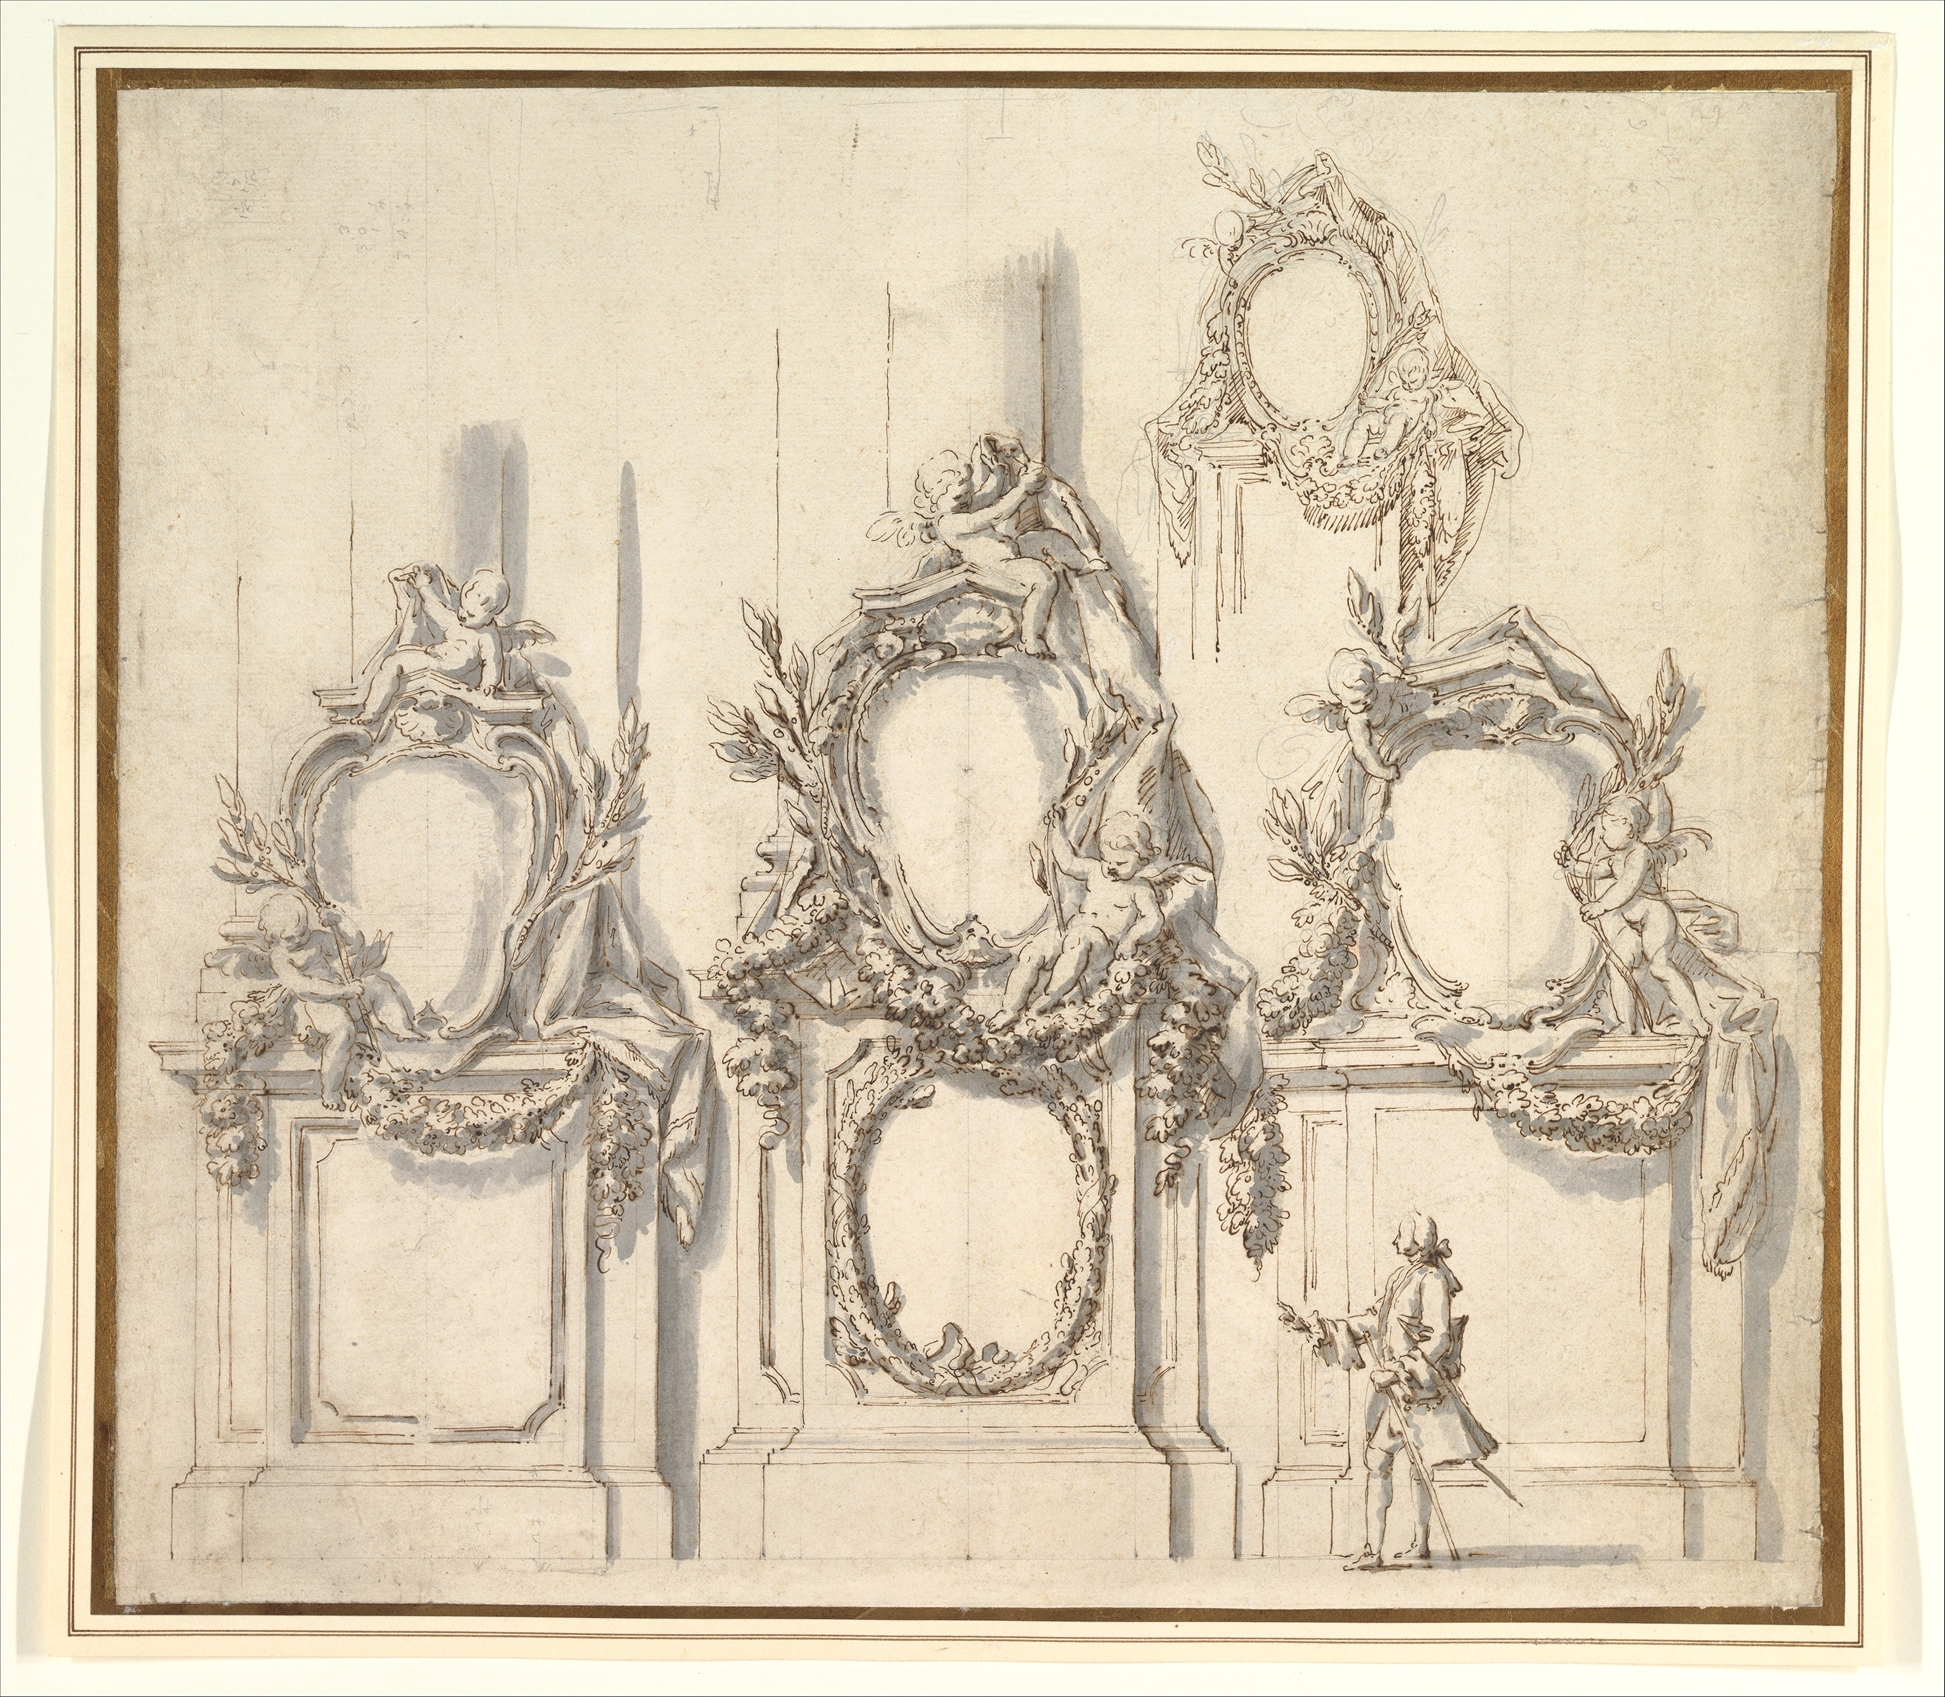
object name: drawing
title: Design for Festival Decorations on the Bases of Piers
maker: carlo marchionni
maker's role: artist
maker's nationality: italian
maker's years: 1702-1786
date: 1702-1786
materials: chalk, ink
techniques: brush, pen, wash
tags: men